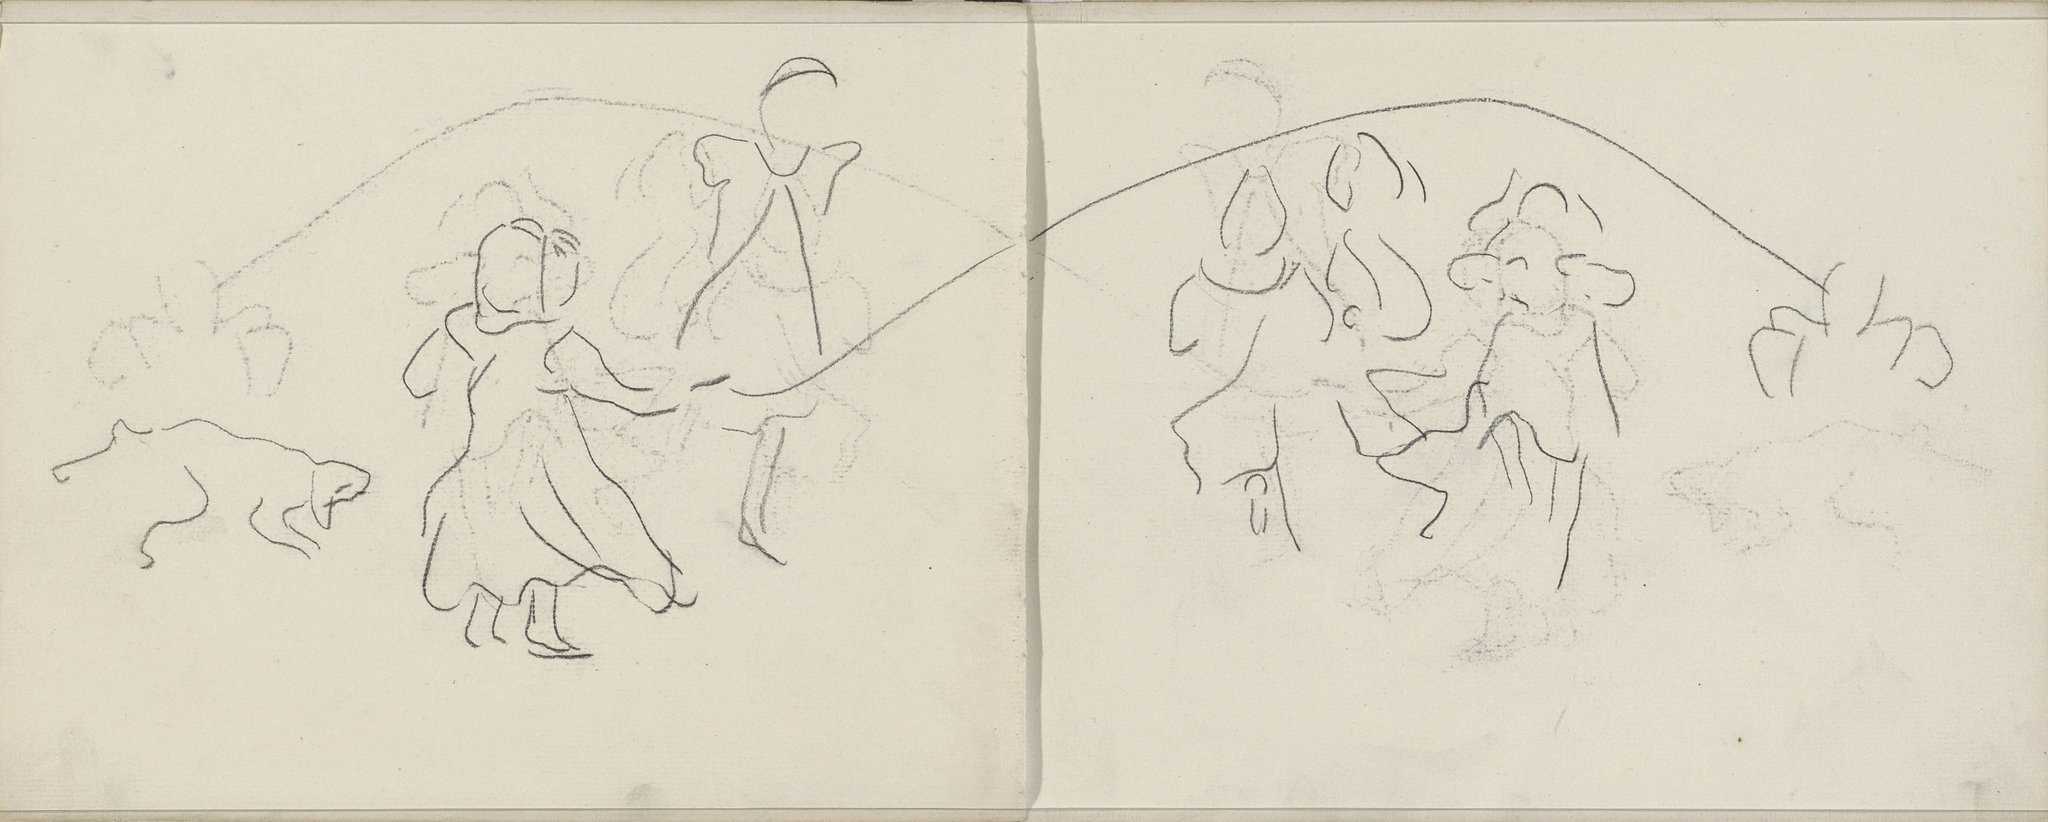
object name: sketchbook leaf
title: Kinderen die touwtje springen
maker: carel adolph lion cachet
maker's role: draughtsman, print maker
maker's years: 1864-1945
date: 1896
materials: chalk, paper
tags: child, jumping-rope games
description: Blad 5 verso en 6 recto uit een schetsboek met 44 bladen.